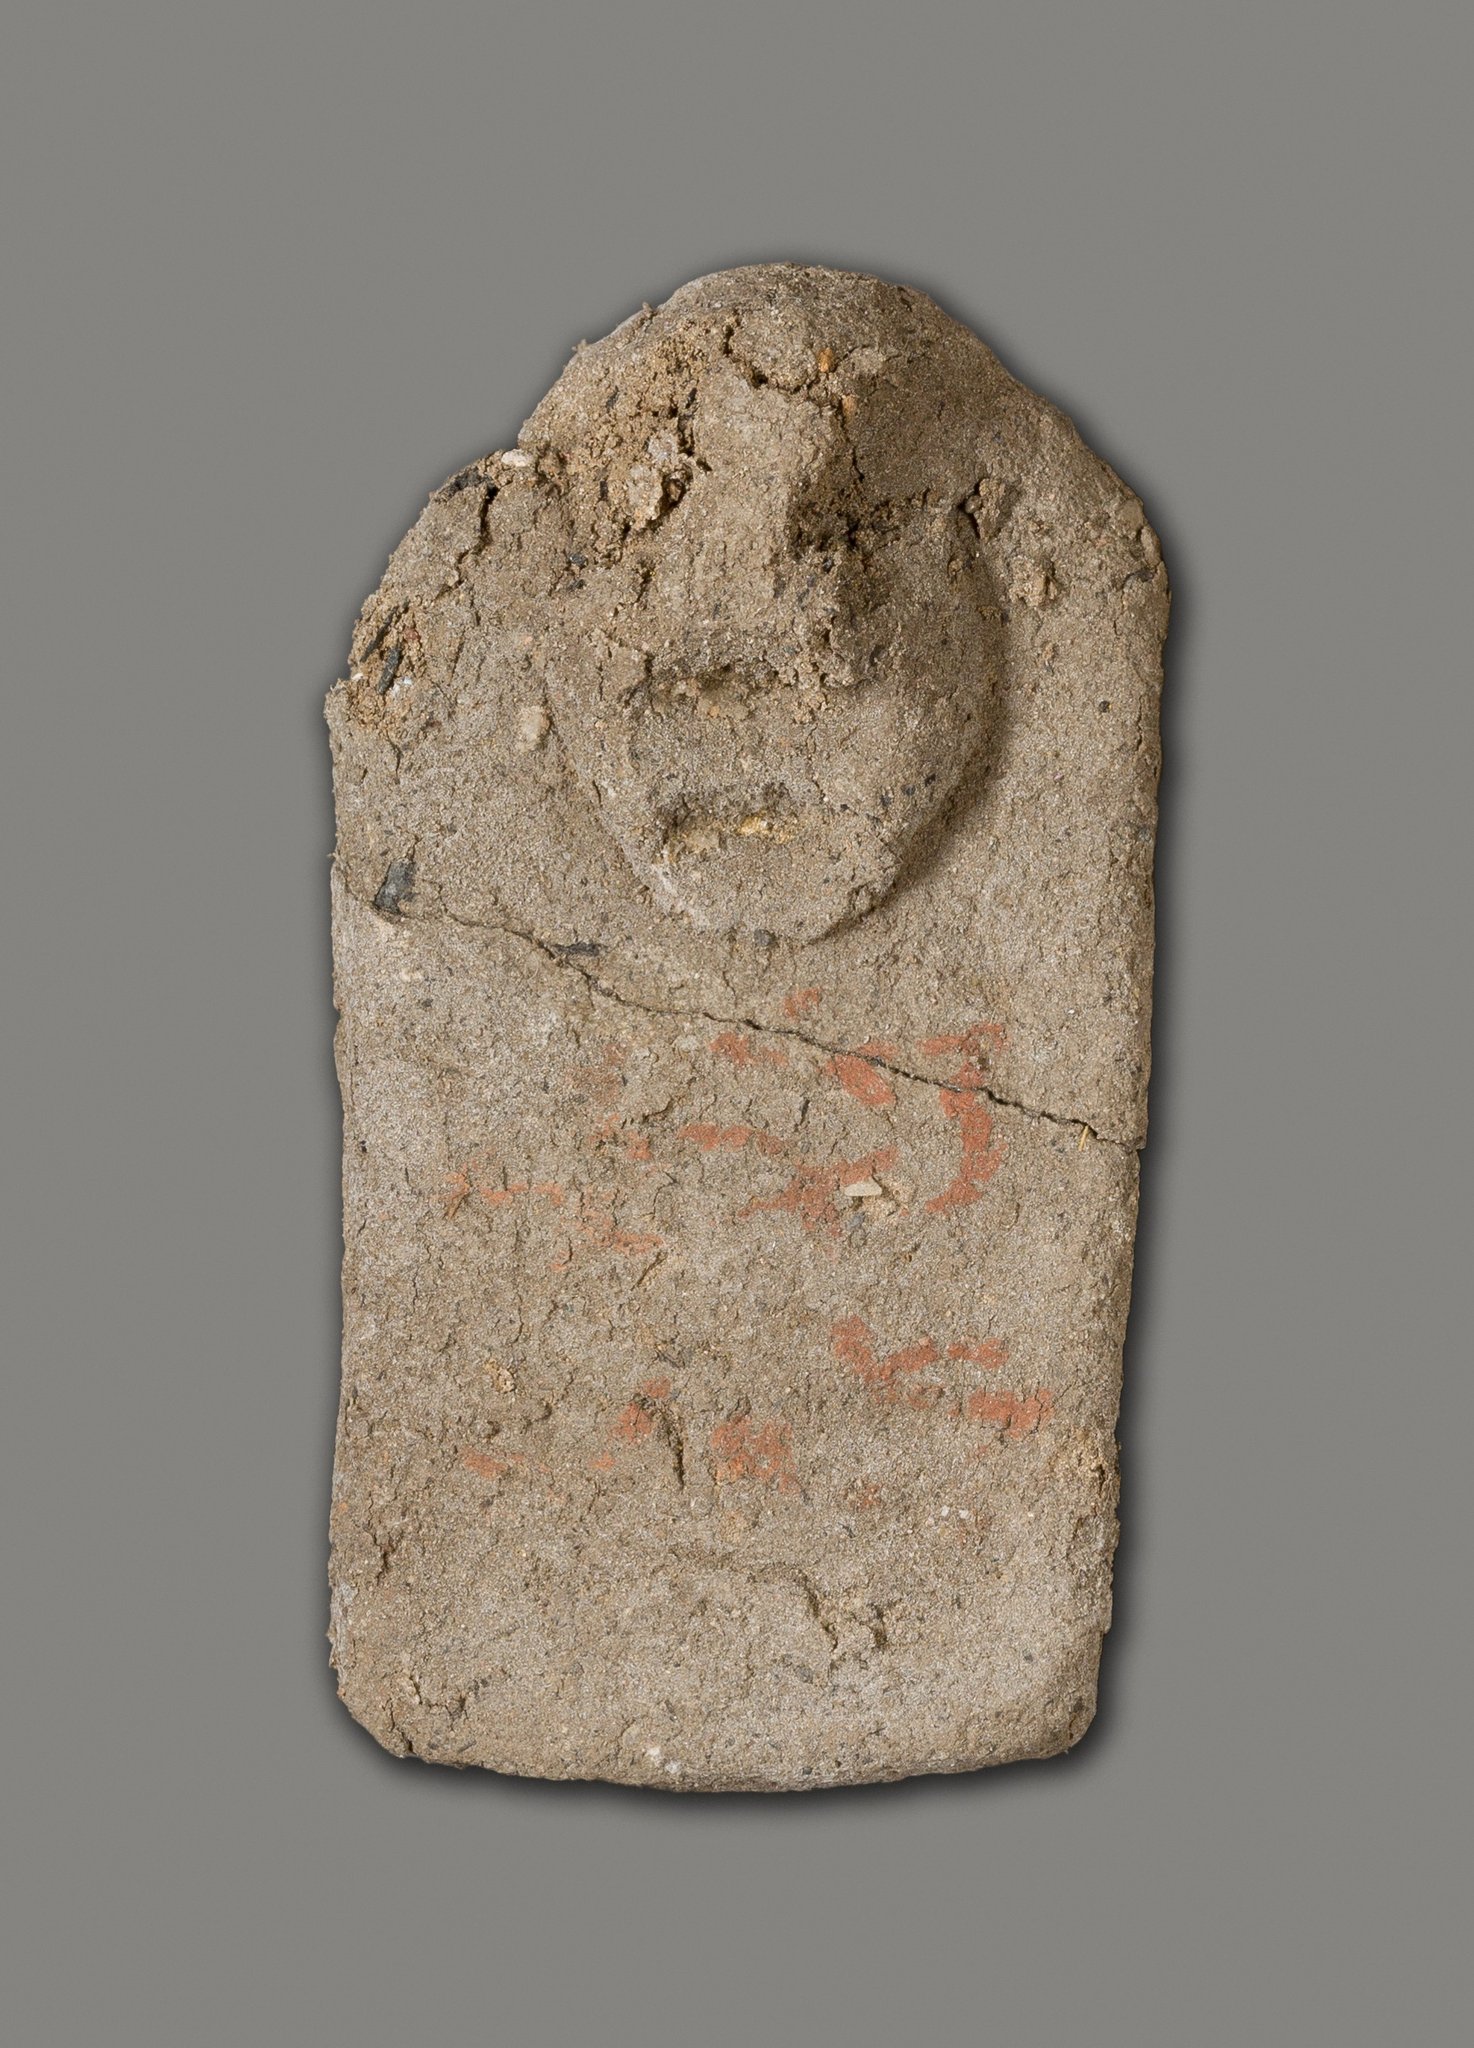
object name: figure, magical, execration, tablet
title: Magical Figure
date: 1802-1550 BCE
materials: clay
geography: egypt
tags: faces